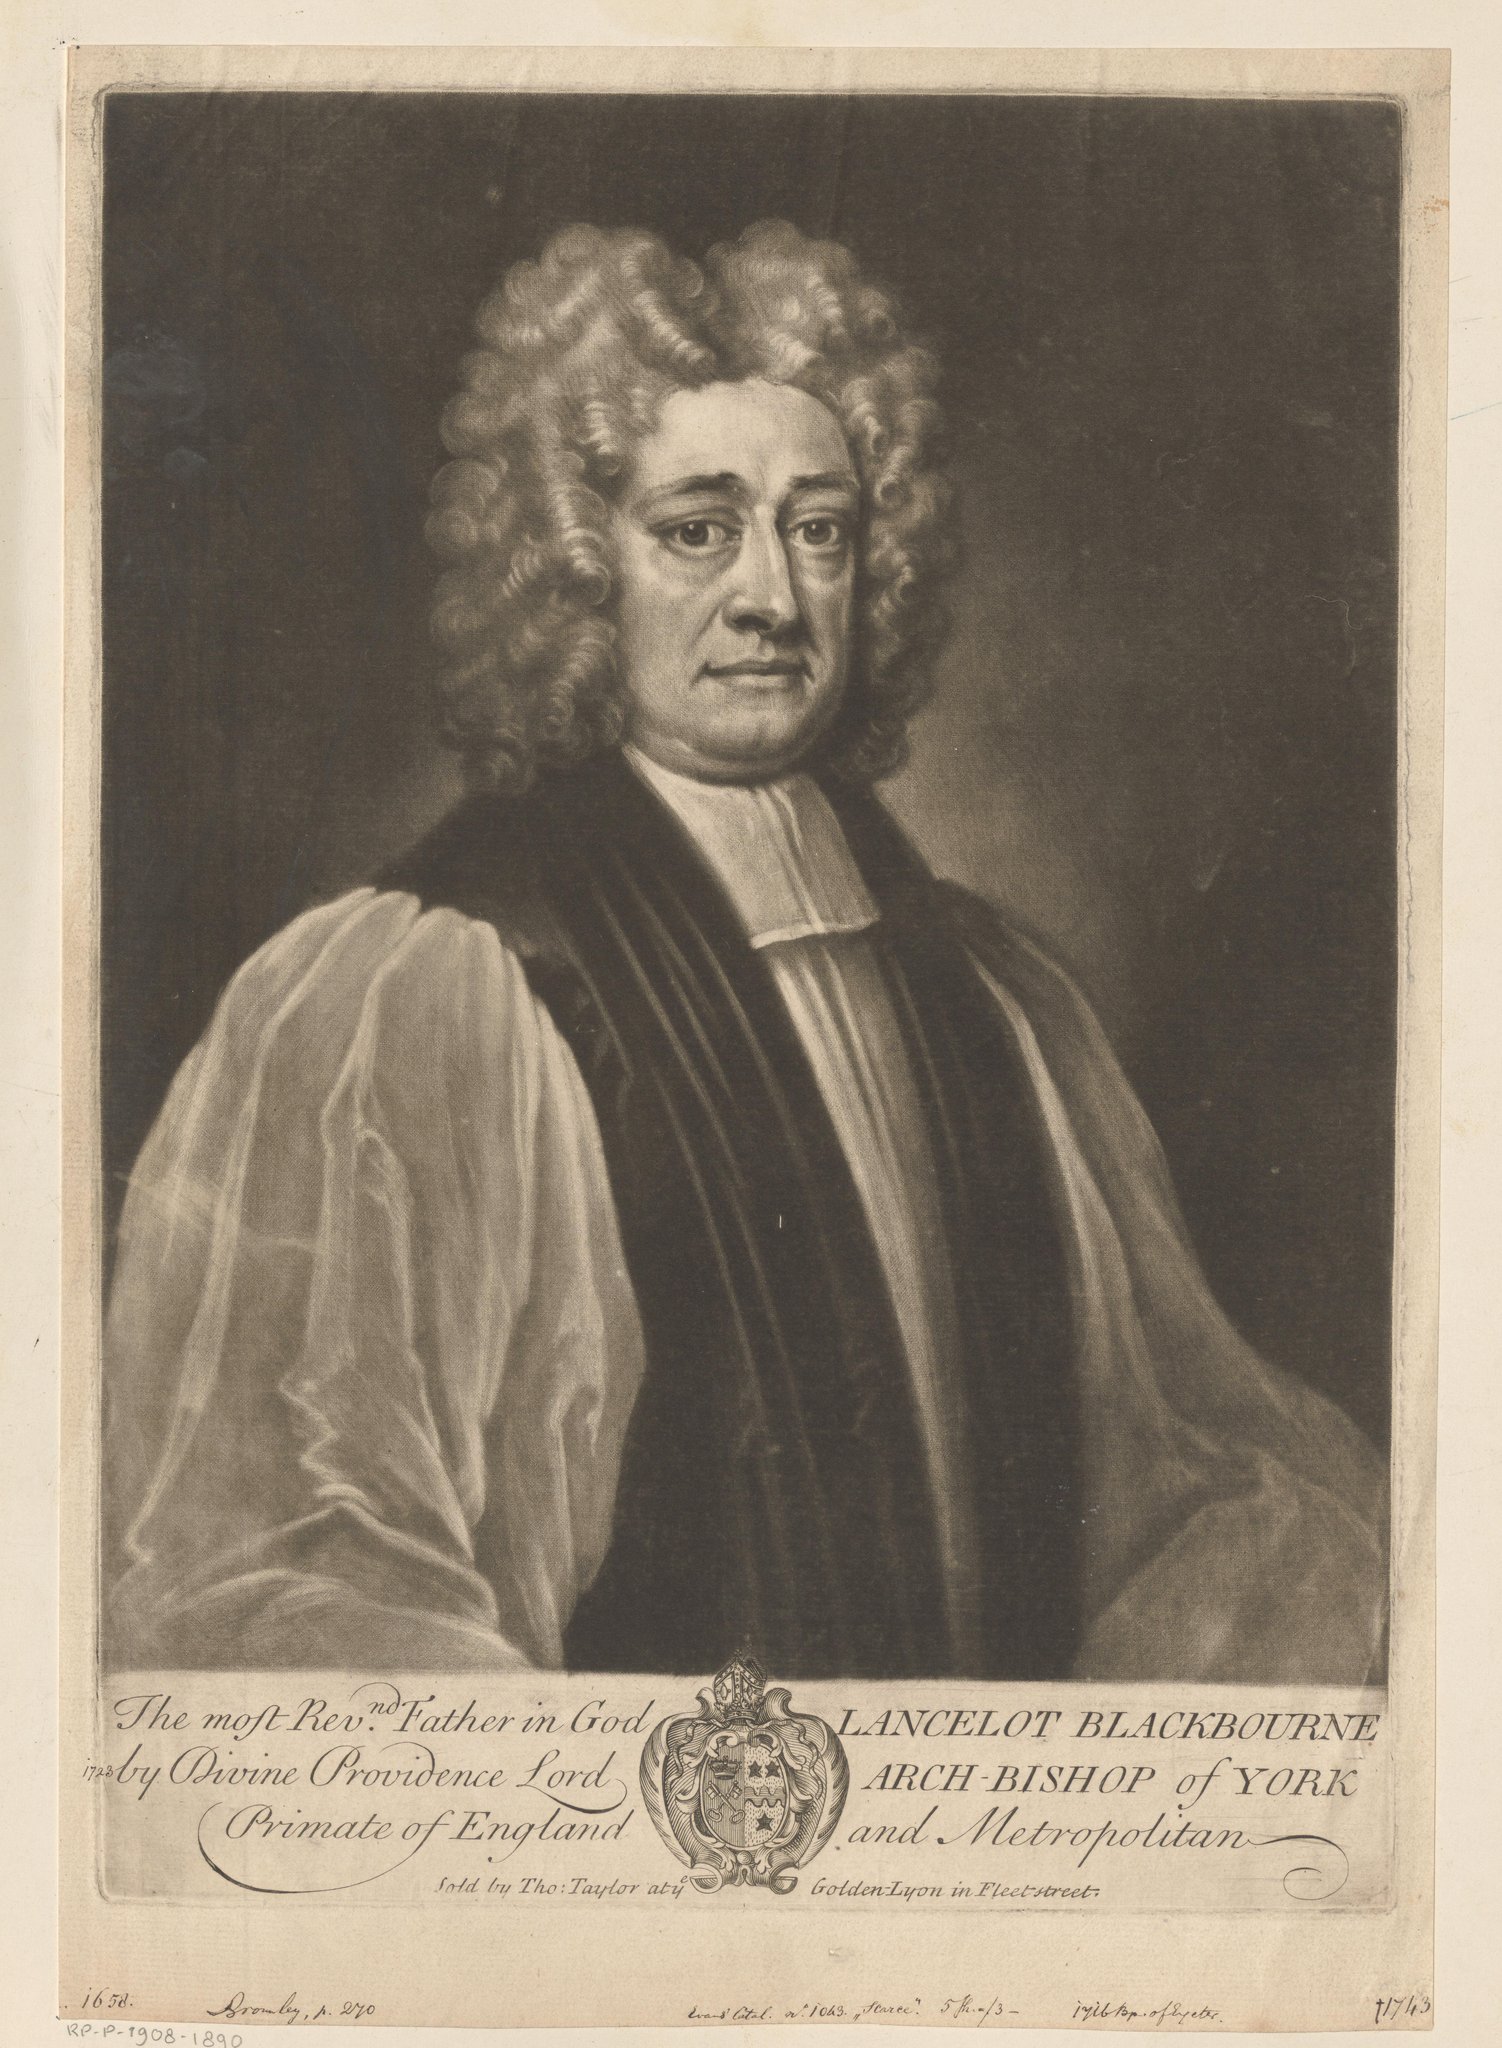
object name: print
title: Portret van Lancelot Blackburne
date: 1724-1725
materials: paper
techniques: engraving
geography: london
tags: london, archbishop, bishop, etc. (roman catholic), historical persons, armorial bearing, heraldry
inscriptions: collector's mark: Lugt 2228, inscription: ‘1658 Bromley p. 270 [...]’